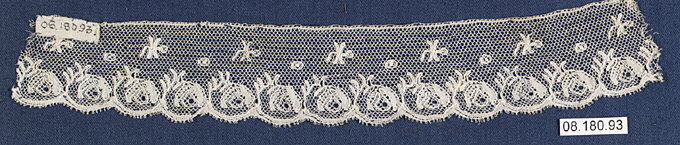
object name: fragment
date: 1801-1900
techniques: lace